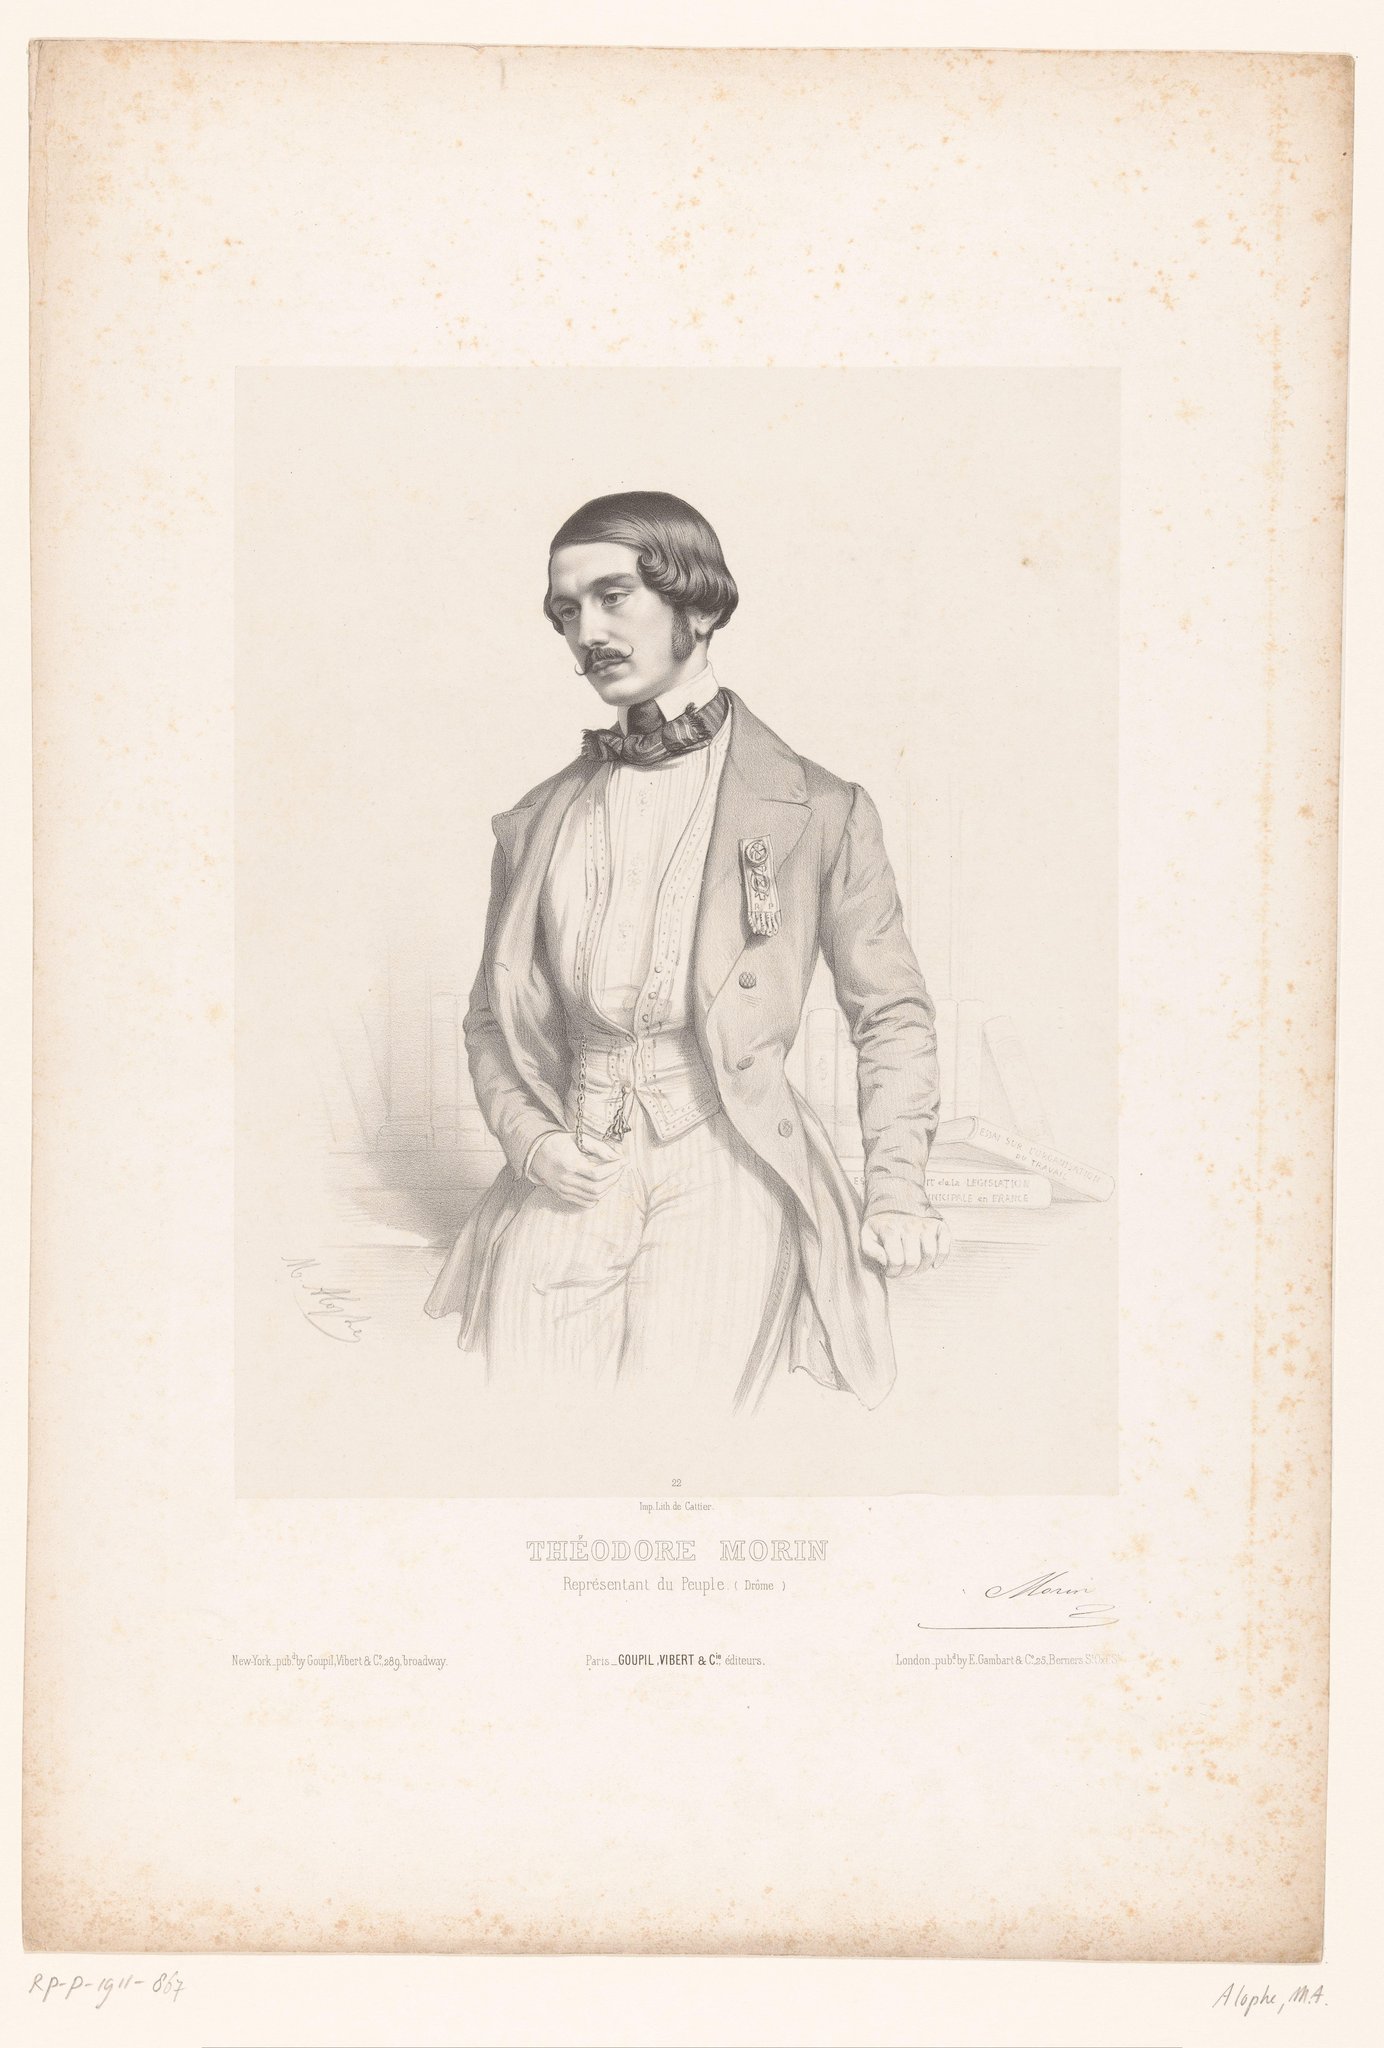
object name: print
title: Portret van de policitus Théodore Morin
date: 1848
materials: paper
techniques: lithography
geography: paris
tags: politician, historical persons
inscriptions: check stamp: Lugt 5004, collector's mark: Lugt 2228